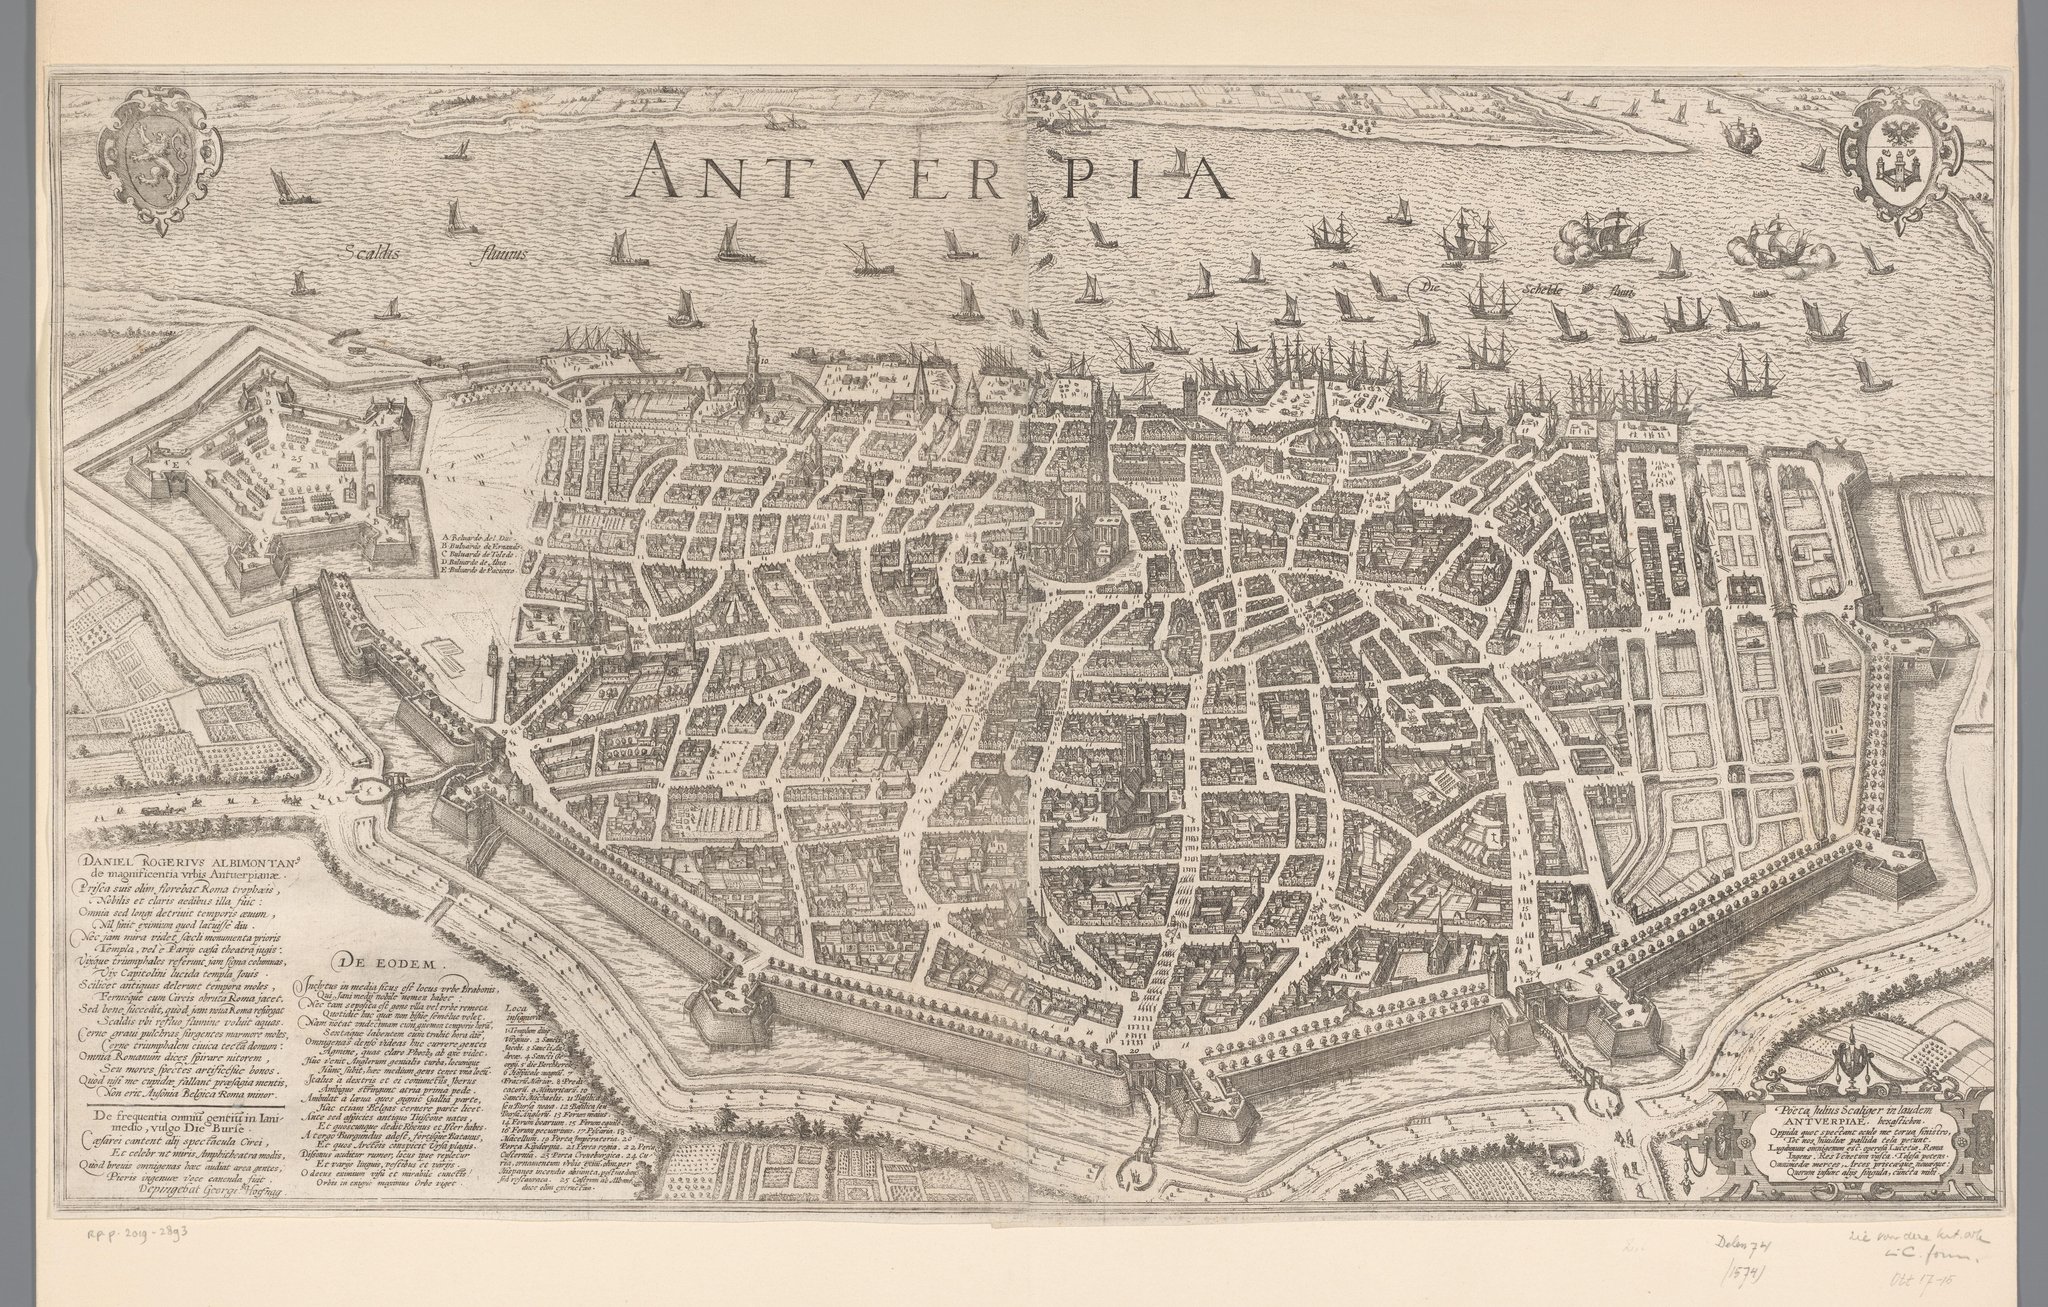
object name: print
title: Plattegrond van Antwerpen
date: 1596-1704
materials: paper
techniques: etching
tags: coat of arms (as symbol of the state, etc.) (+ city; municipal), fortified city, maps of cities, prospect of city, town panorama, silhouette of city, antwerp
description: Prent verschenen in: Beschreibung und Contrafactur de vornembster Stät der Welt. 6 dln. S.l.: Braun en Hogenberg, 1574-1618.